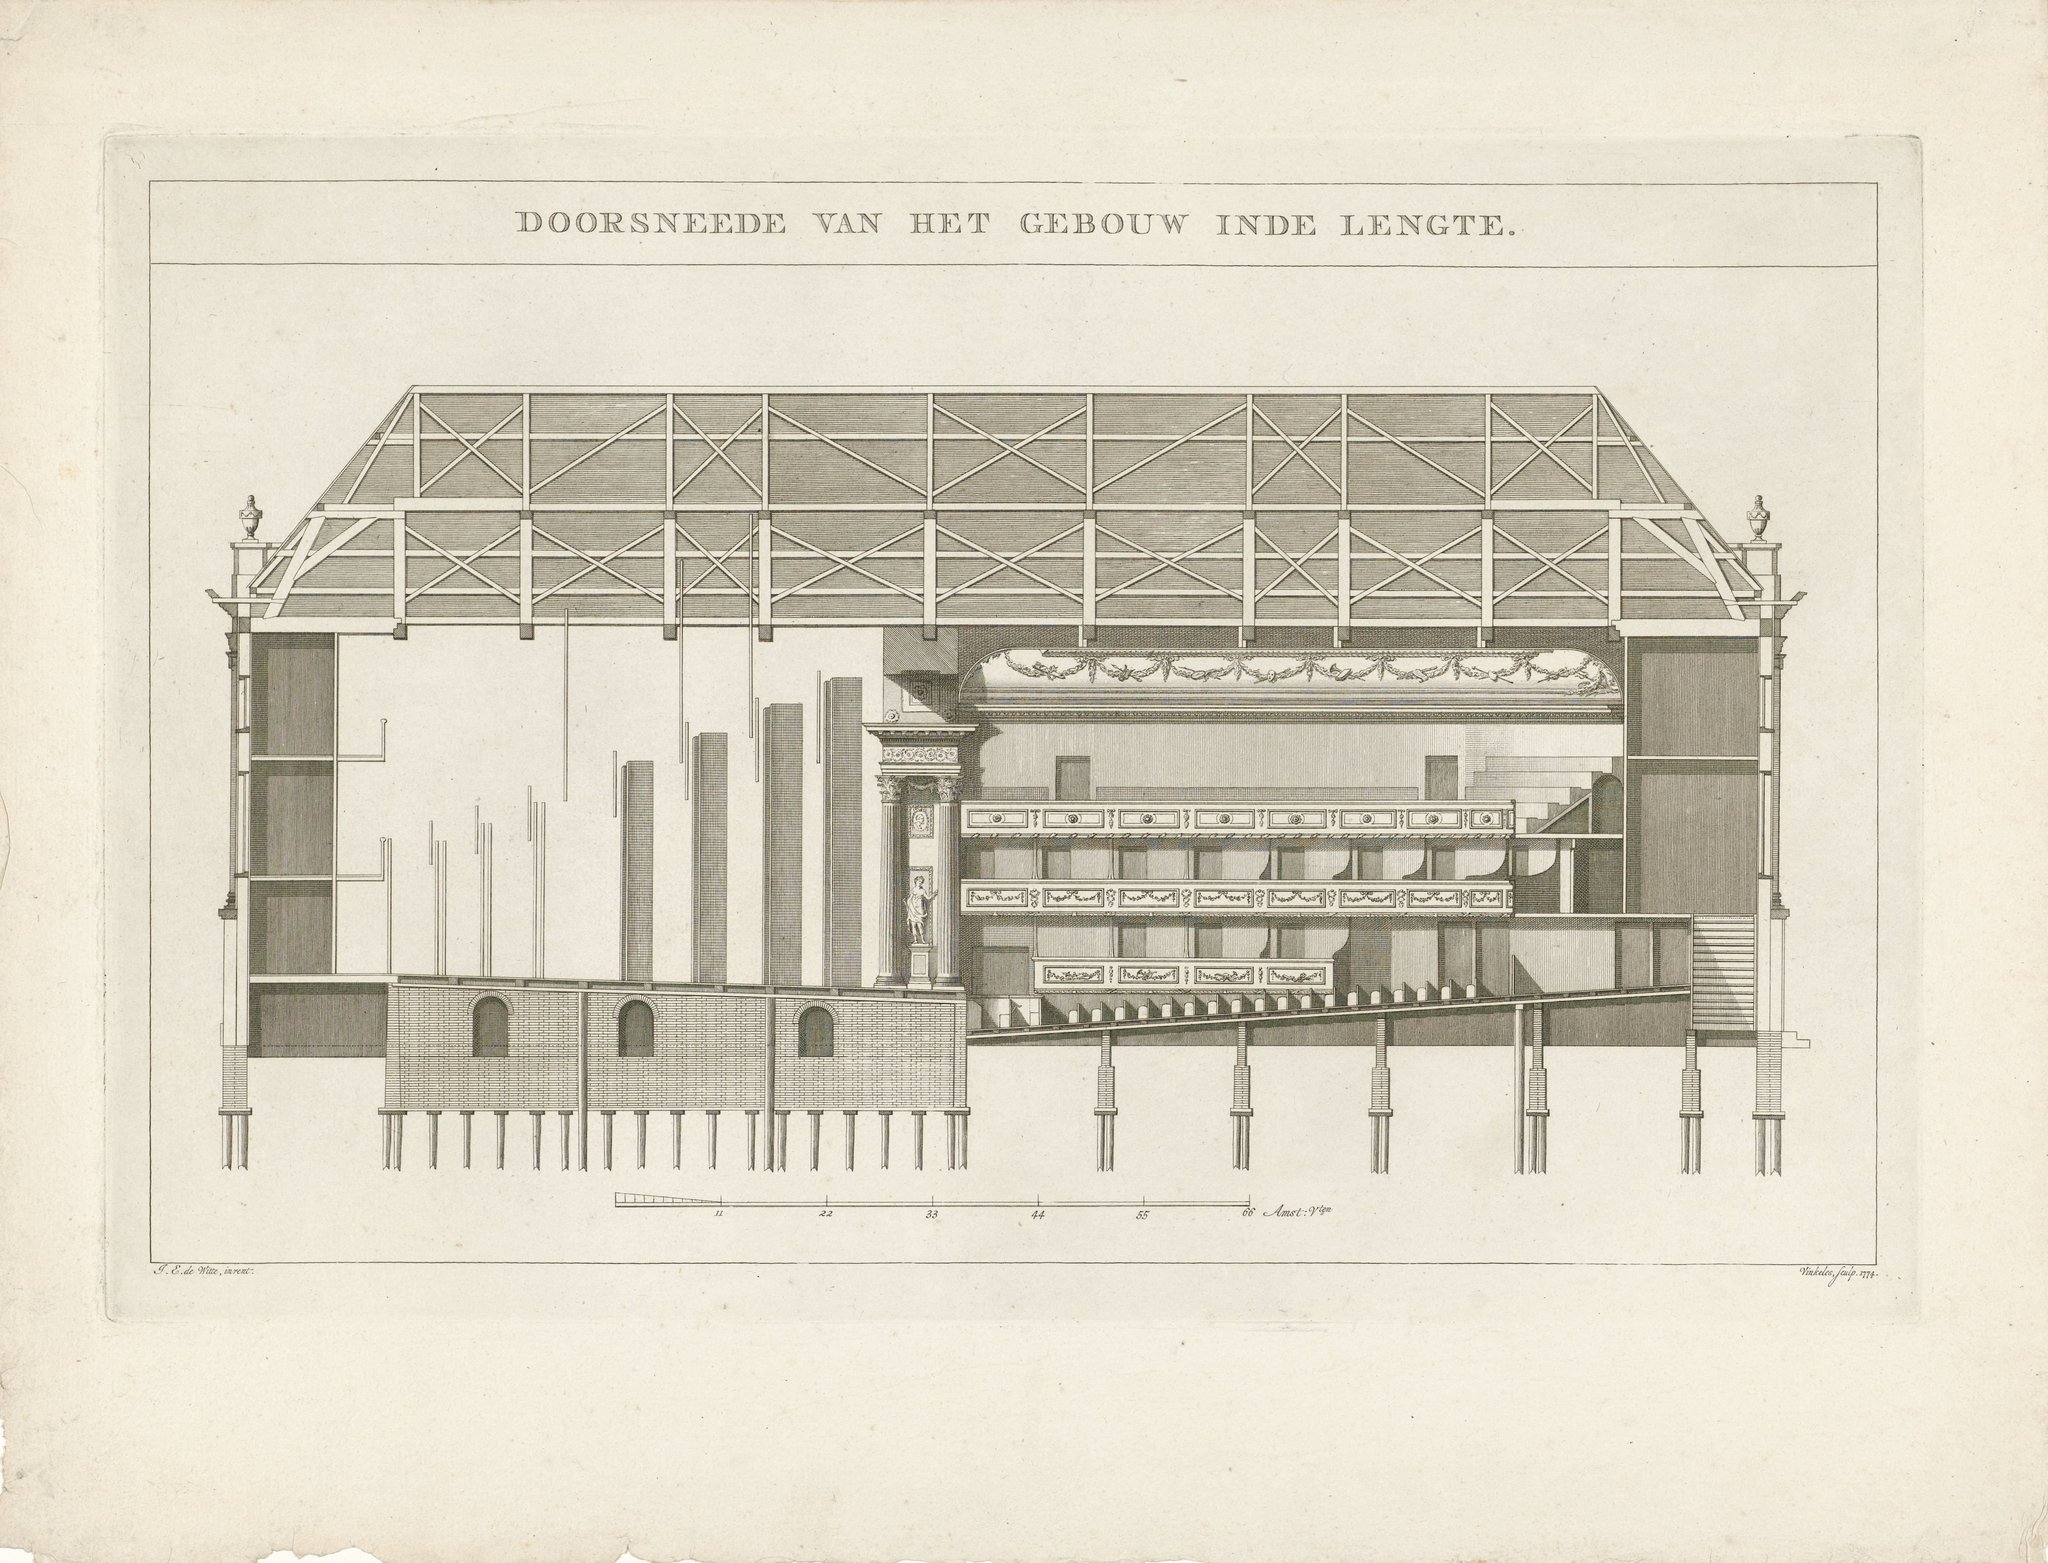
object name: print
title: Doorsneede van het gebouw inde lengte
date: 1774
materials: paper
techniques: etching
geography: amsterdam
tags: jacob eduard de witte, theatre (building), architectural design or model, section ~ architectural design or model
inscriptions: collector's mark: Lugt 2228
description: Doorsnede van het gebouw in de lengte. Onderdeel van een reeks van veertien platen van de nieuwe Schouwburg te Amsterdam, 1774.